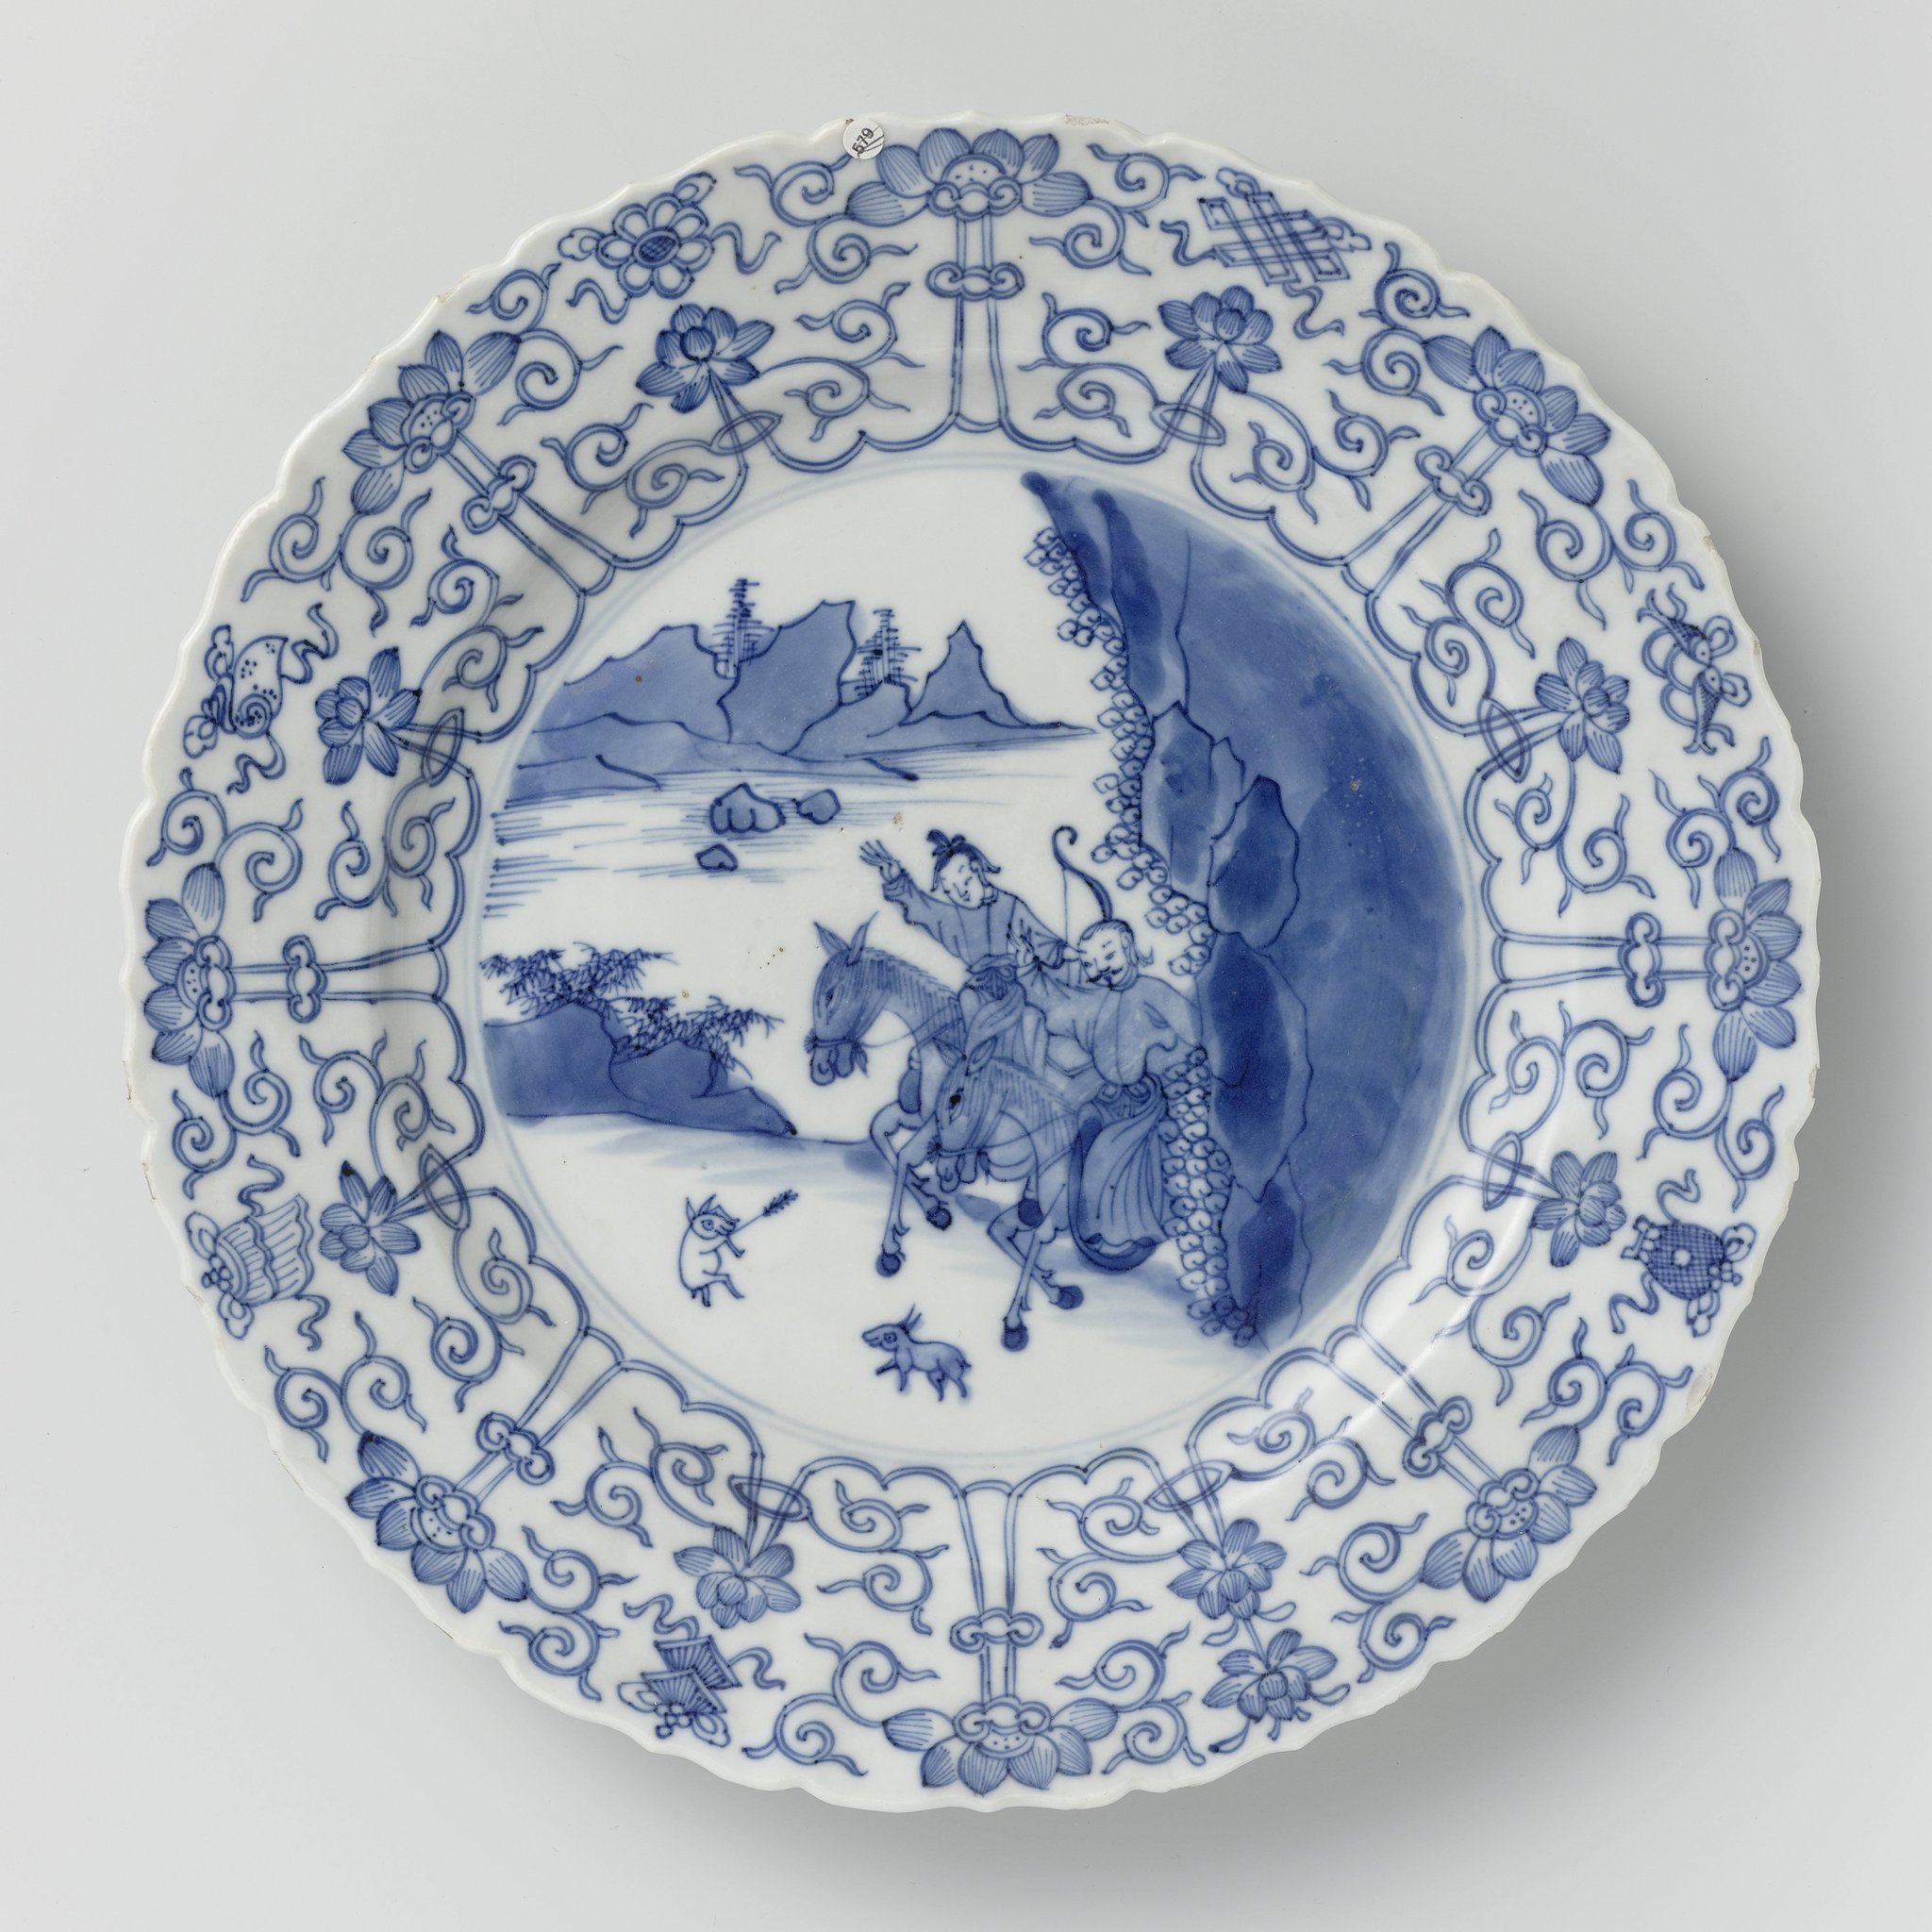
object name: platter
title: Saucer-dish with hunting scene, lotus scrolls and auspicious symbols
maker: Anonymous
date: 1700-1724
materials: cobalt, glaze, paint, porcelain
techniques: firing, forming, turning, vitrification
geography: china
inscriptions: mark: ‘大 明 成 化 年 製 dà míng Chéng huà nián zhì’